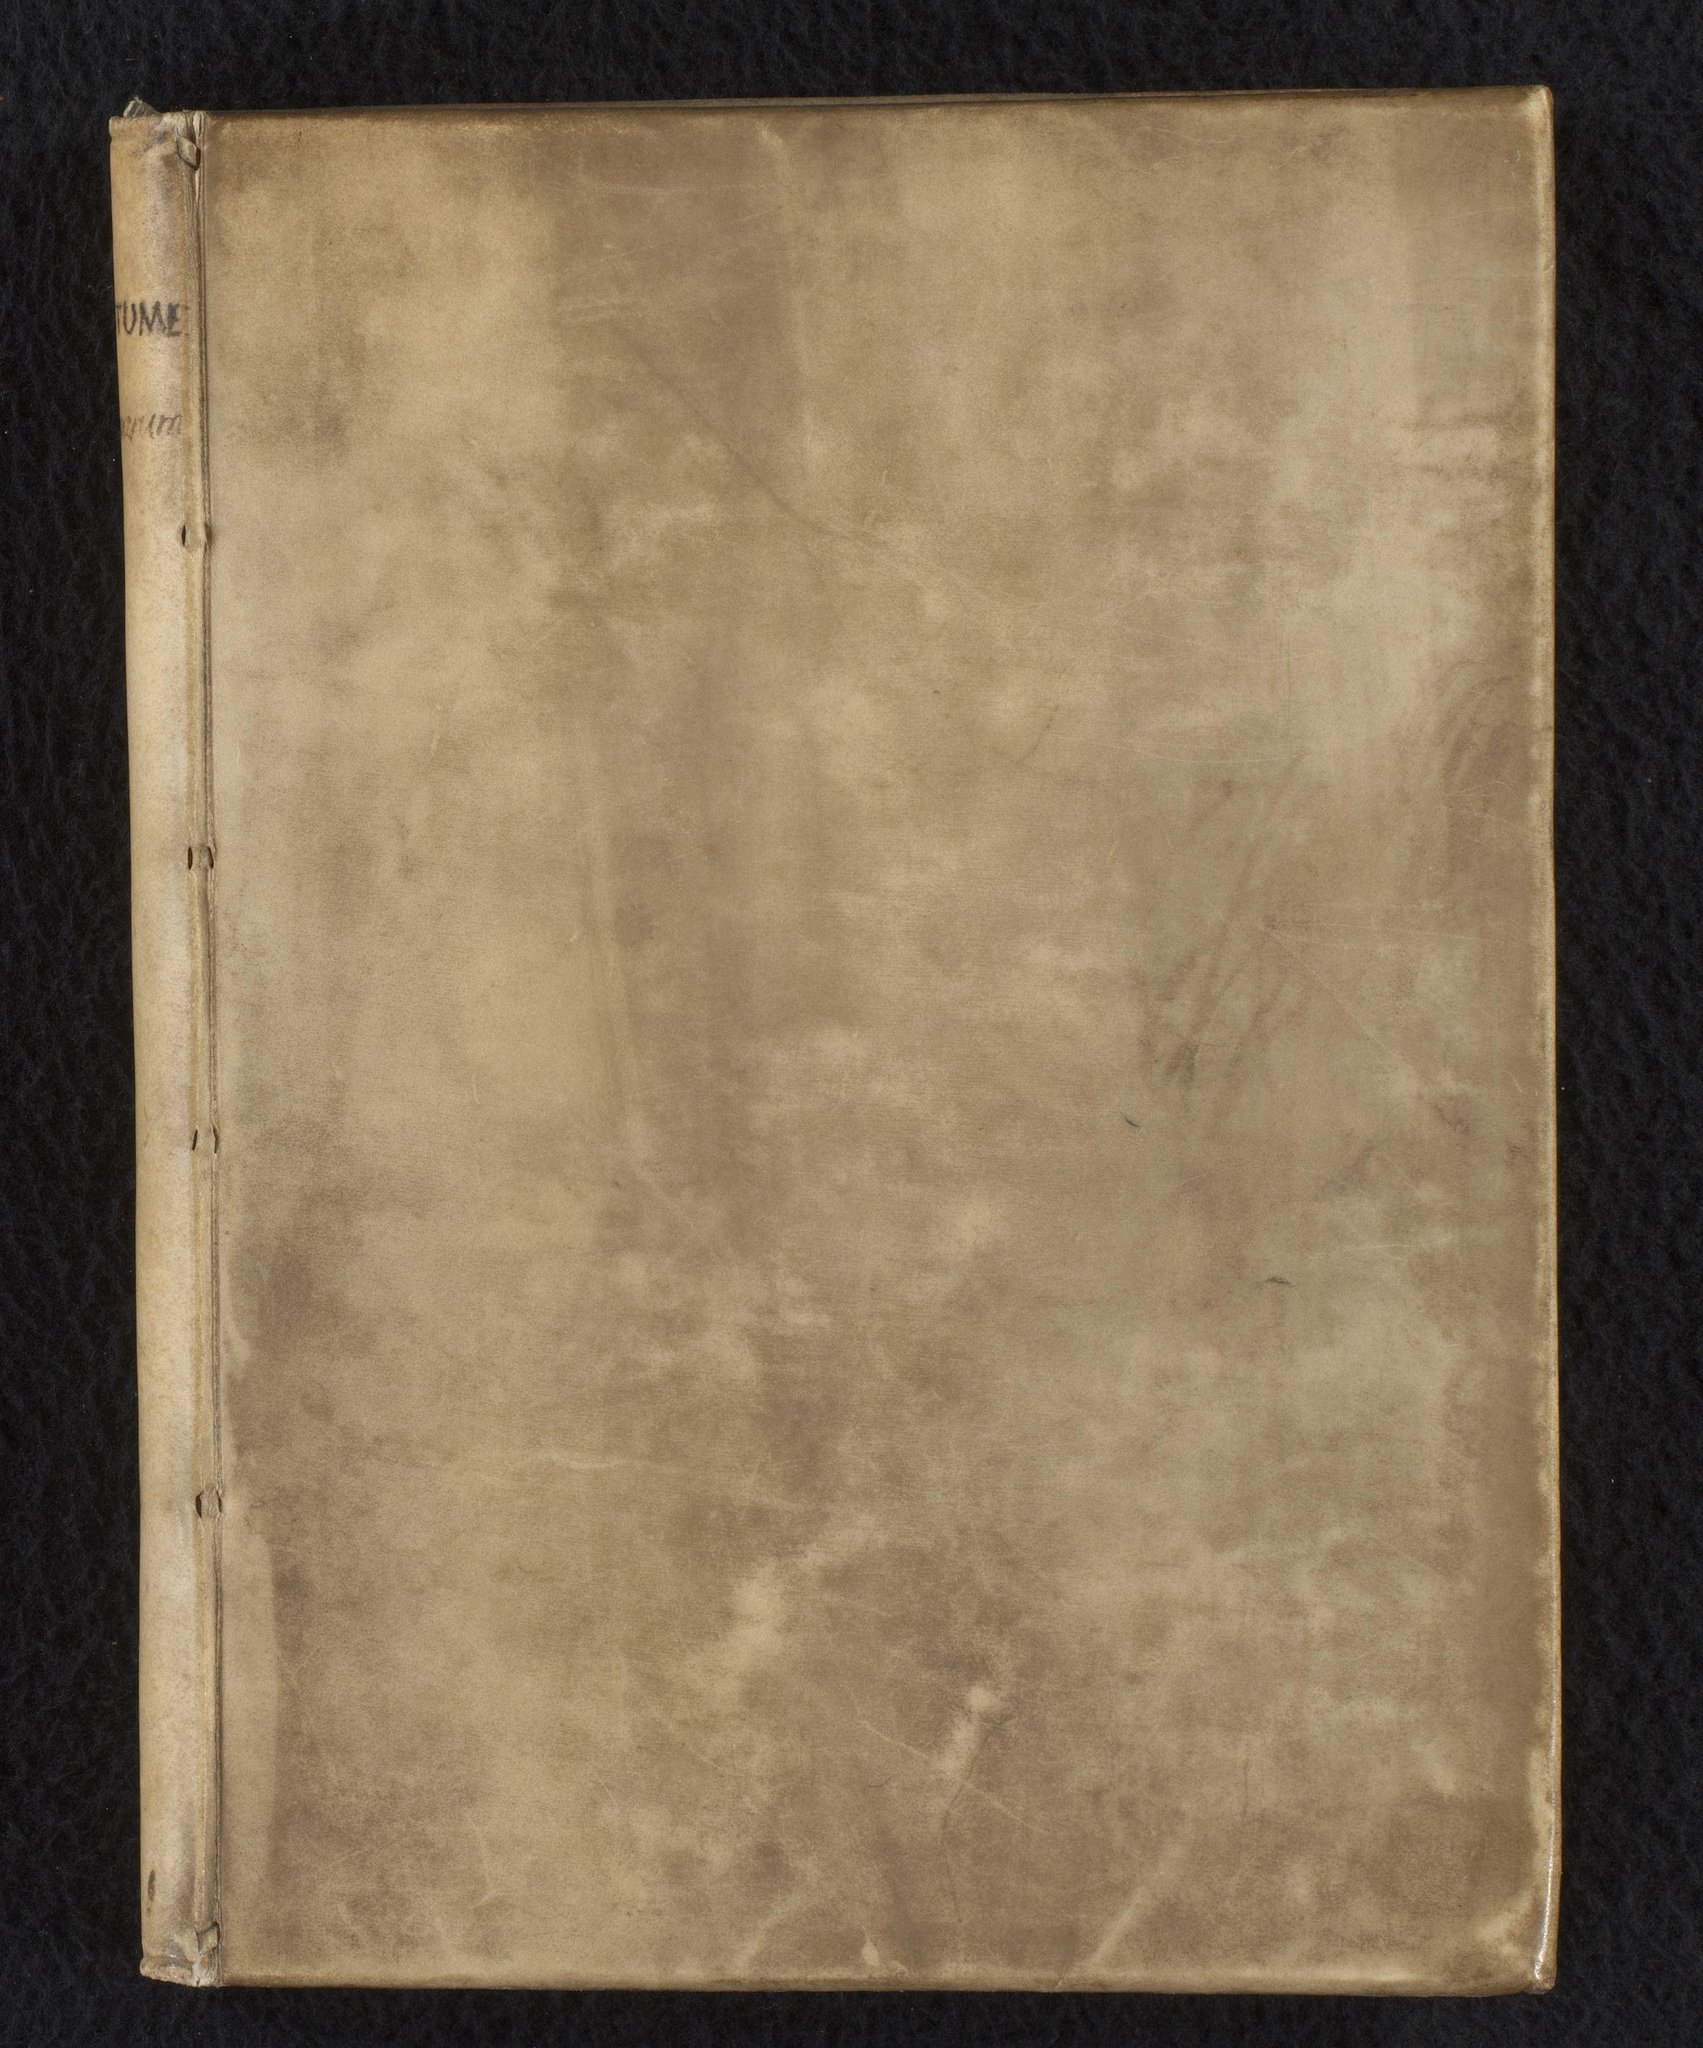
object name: prentrecueil, prentenalbum, prentalbum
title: Diversarum gentium nostrae aetatis habitus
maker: enea vico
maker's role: draughtsman, print maker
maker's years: 1523-1567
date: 1558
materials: paper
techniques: engraving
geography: venice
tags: clothes, costume (+ women's clothes)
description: Perkamenten bandje met de serie 'Diversarum gentium nostrae aetatis habitus' van Enea Vico, gebonden met 11 etsen van Giovanni Orlando en de serie 'Figures des différents habits des chanoines reguliers en ce siècle': 30 gravures met de kleding van de priesters, monniken en nonnen uit verschillende orden, door Le Doyen.